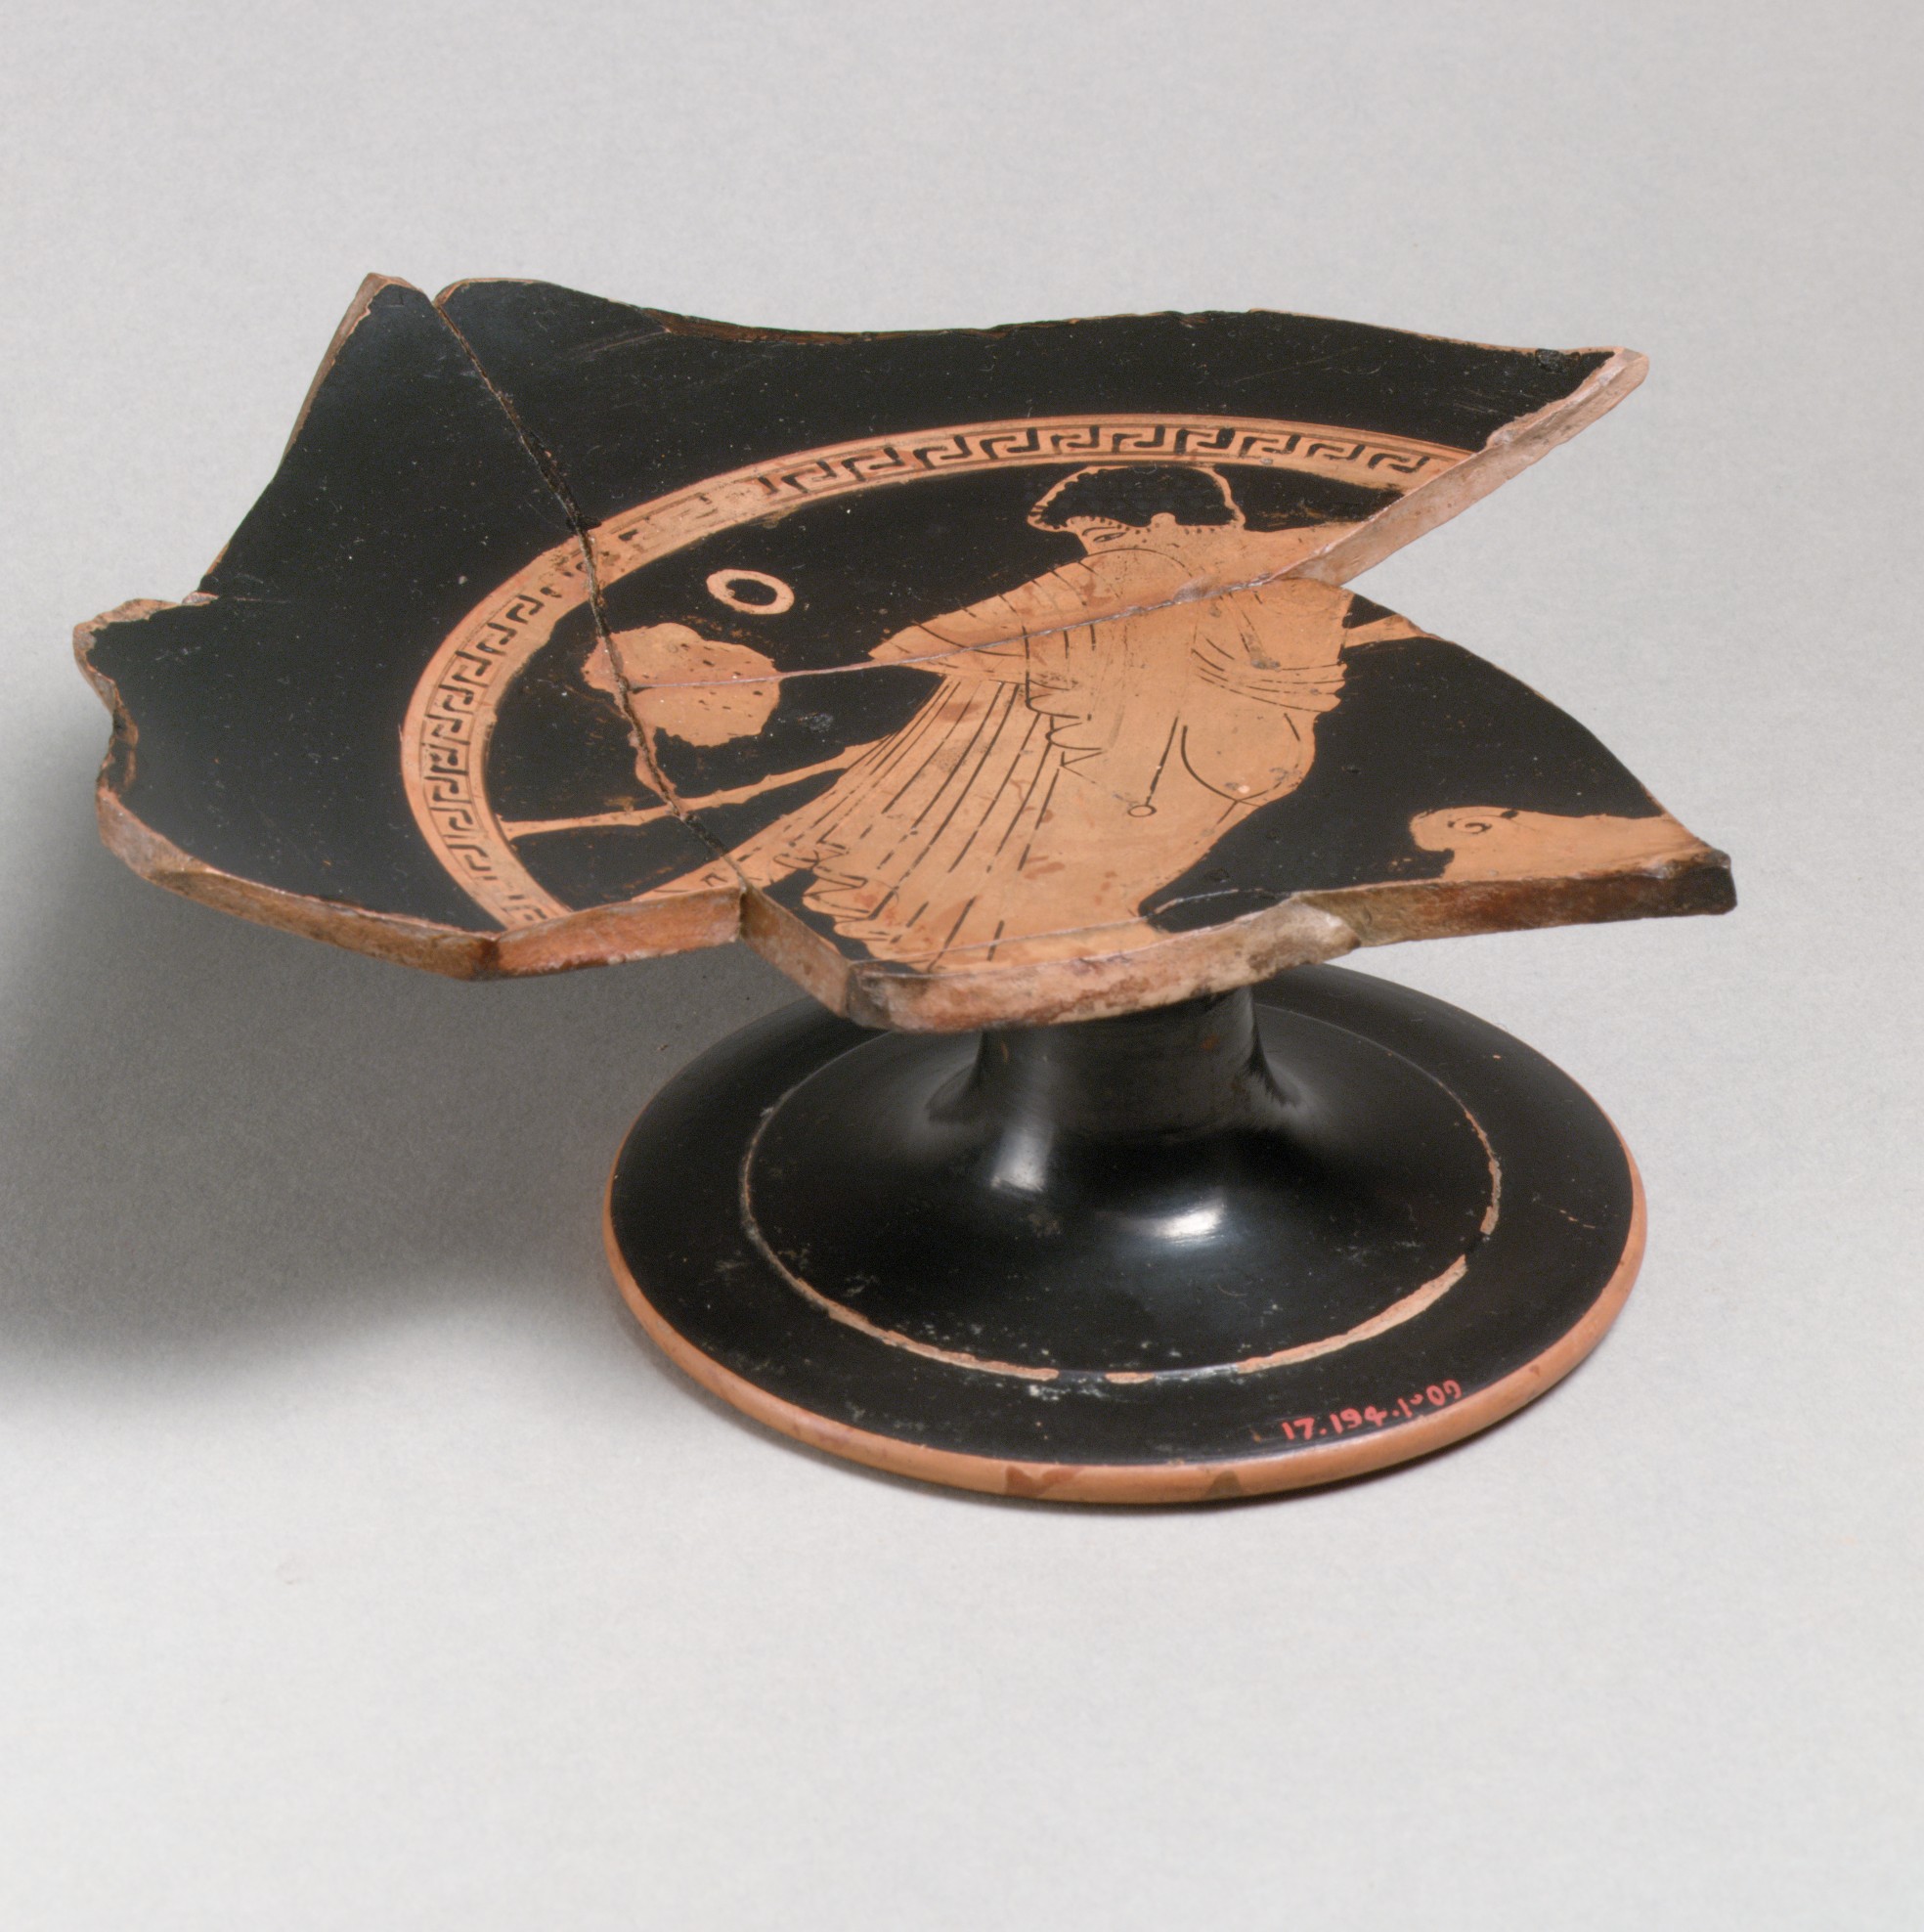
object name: kylix fragment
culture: greek, attic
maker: painter of berlin 2268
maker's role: artist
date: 510-500 BCE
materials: terracotta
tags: human figures